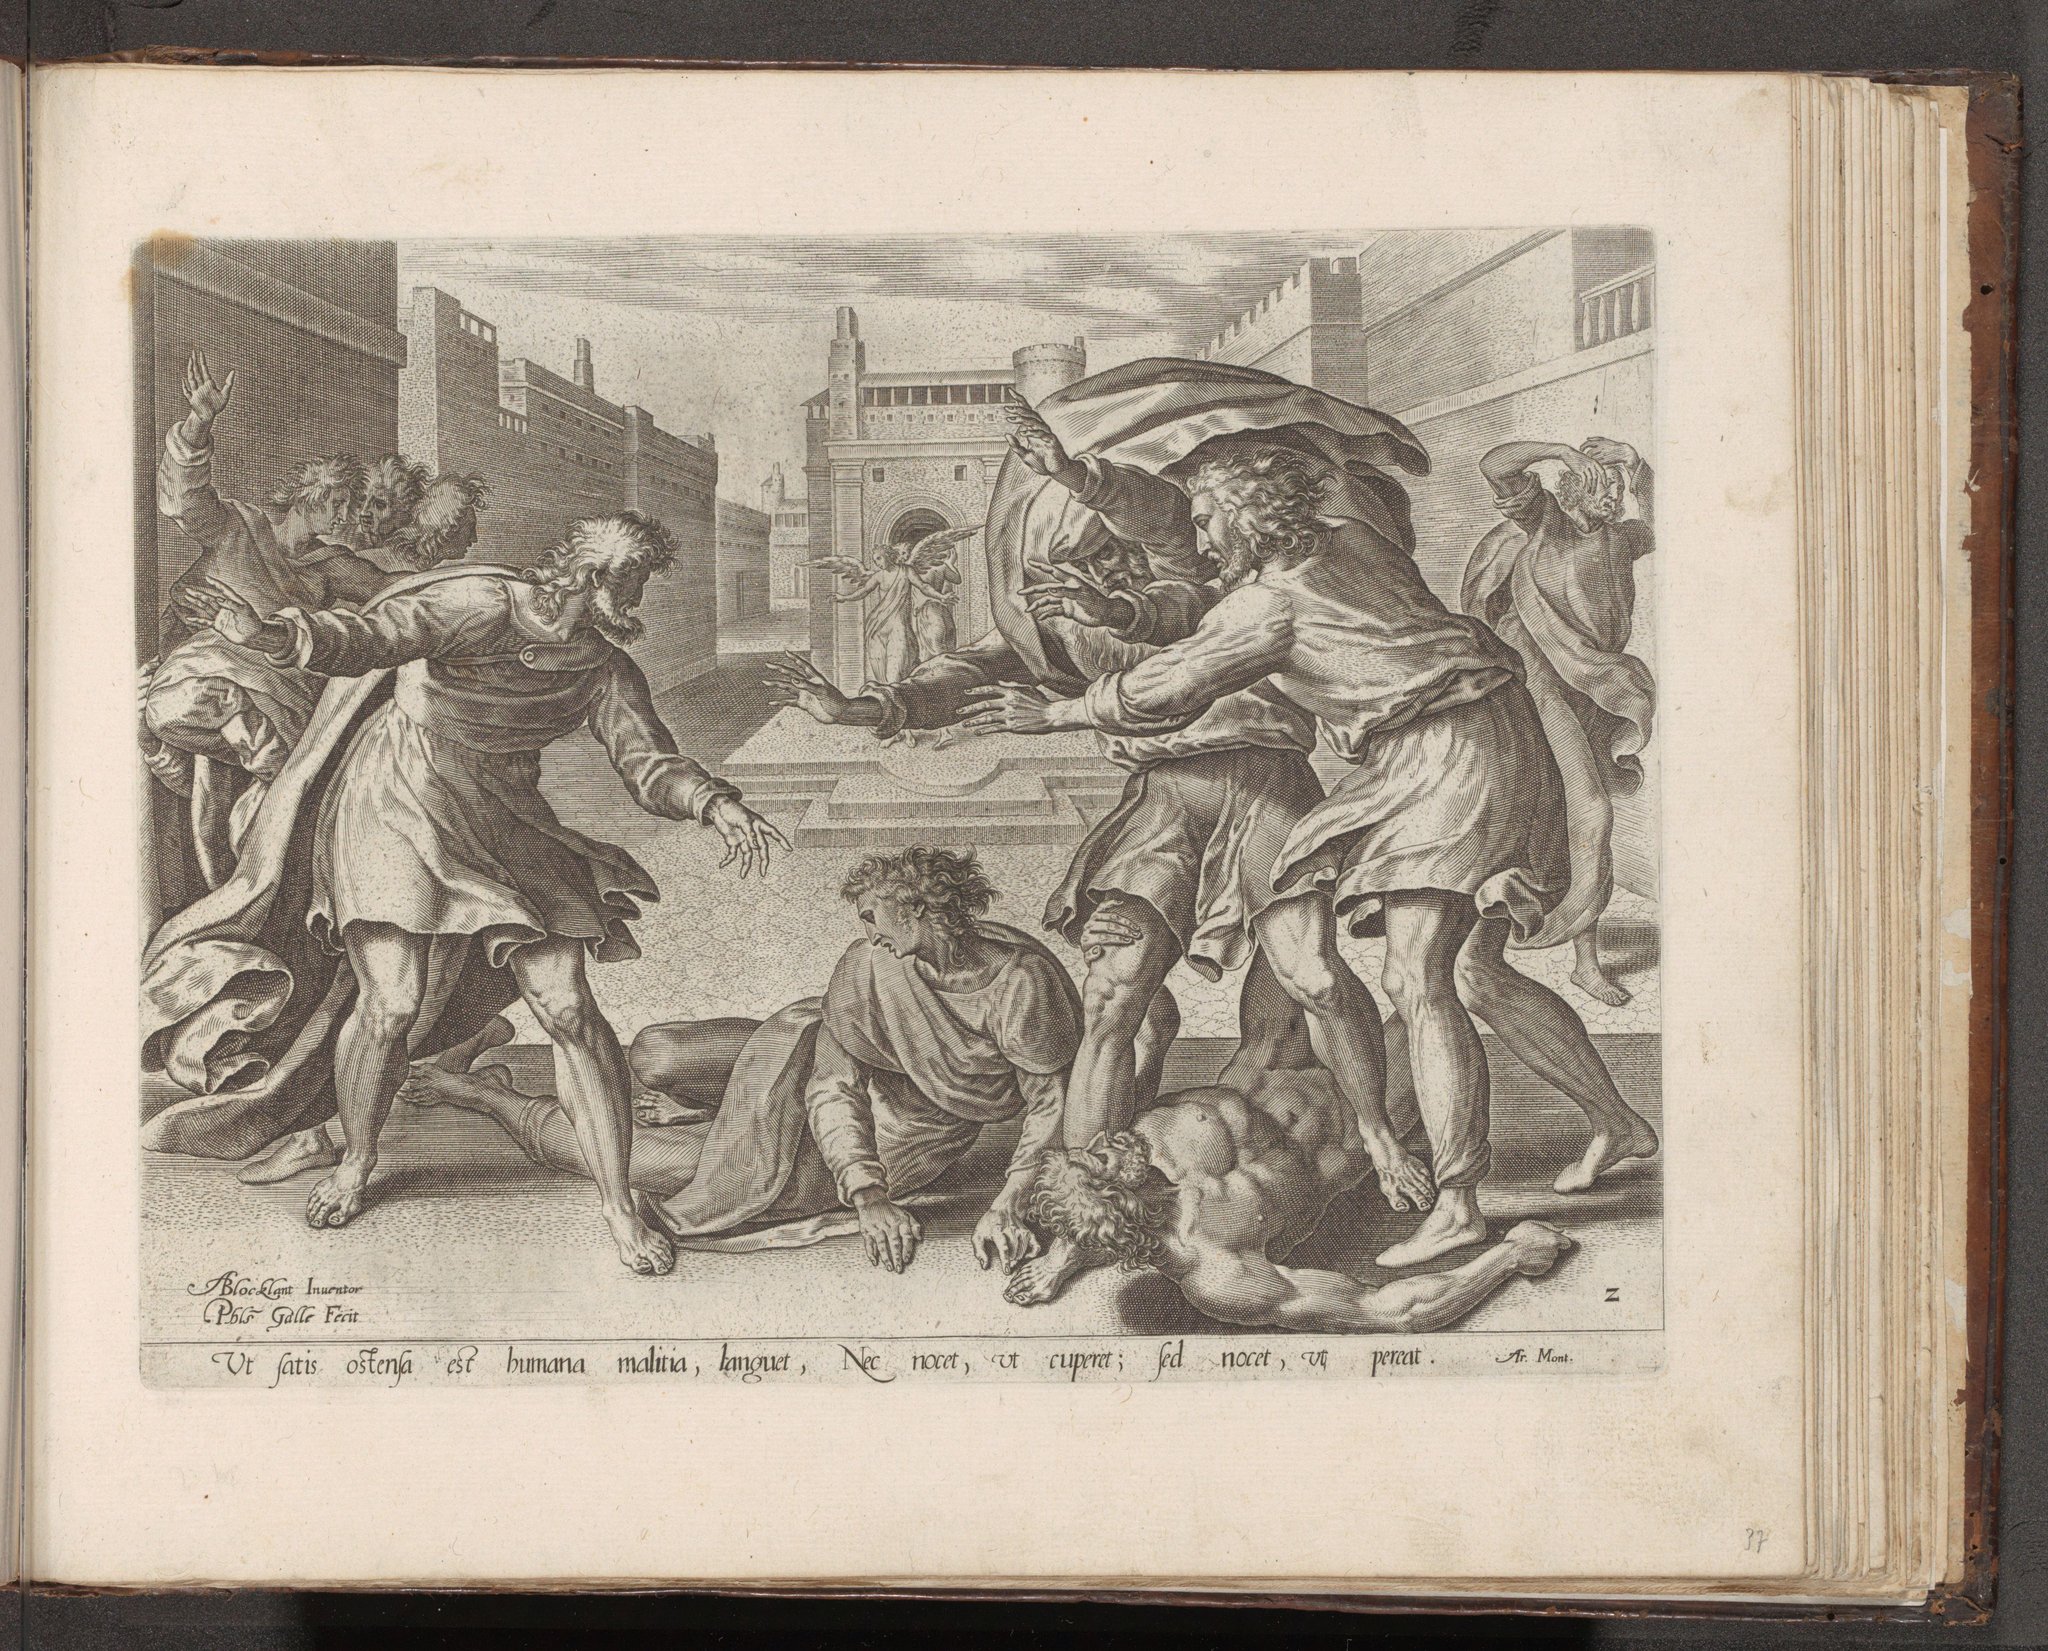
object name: print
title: Thesaurus sacrarum historiaru[m] veteris testame[n]ti, elega[n]tissimis imaginibus expressu[m] excelle[n]tissimoru[m] in hac arte viroru[m] opera: nu[n]c primu[m] in luce[m] editus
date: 1571-1572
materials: paper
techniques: engraving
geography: antwerp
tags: the two angels intervene and strike the mob that surround lot's house with blindness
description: De mannen die bij het huis van Lot zijn verzameld worden door God met blindheid geslagen. Twee van hen liggen op de grond. Op de achtergrond de twee engelen voor het huis van Lot. Onder de voorstelling een verklarende tekst in het Latijn. Prent maakt deel uit van een album.